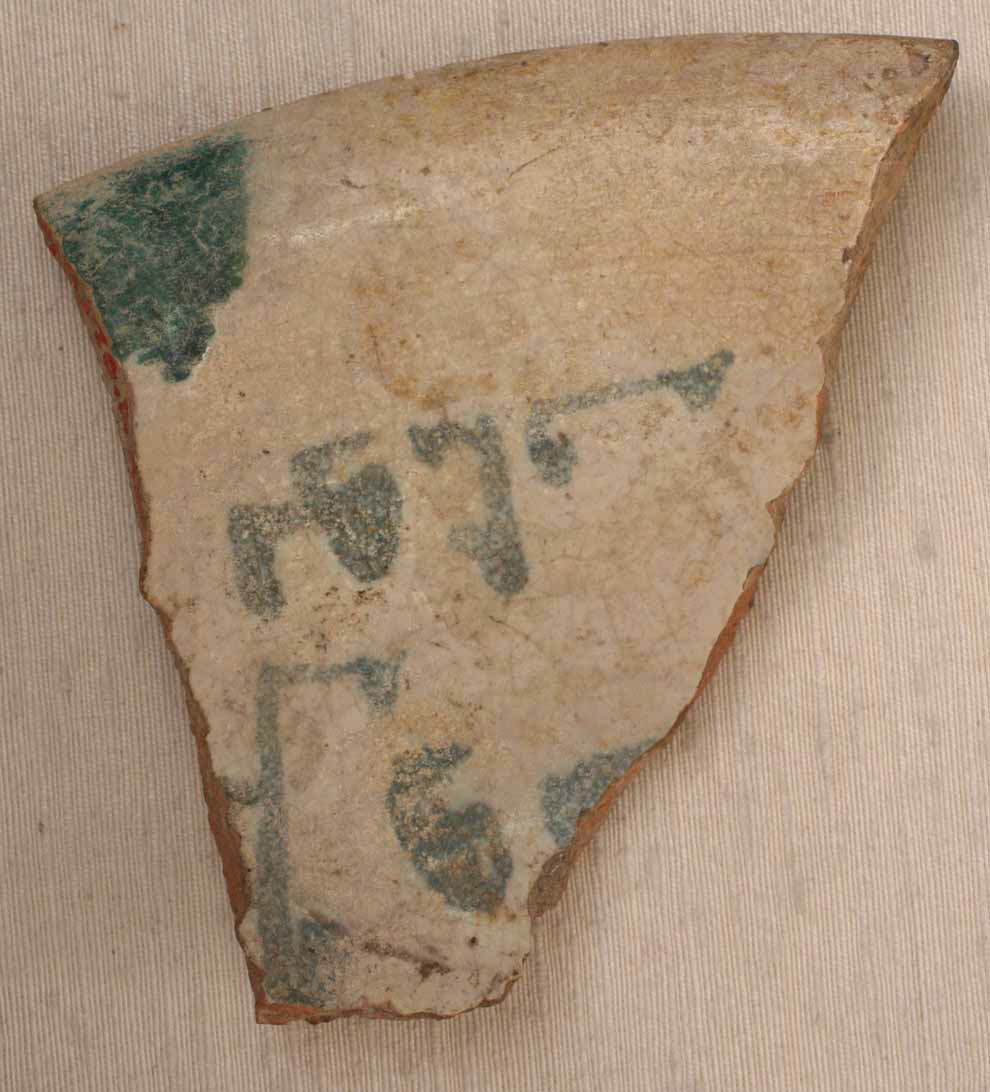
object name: fragment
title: Ceramic Fragment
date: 801-900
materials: earthenware, glaze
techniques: glazing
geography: iran